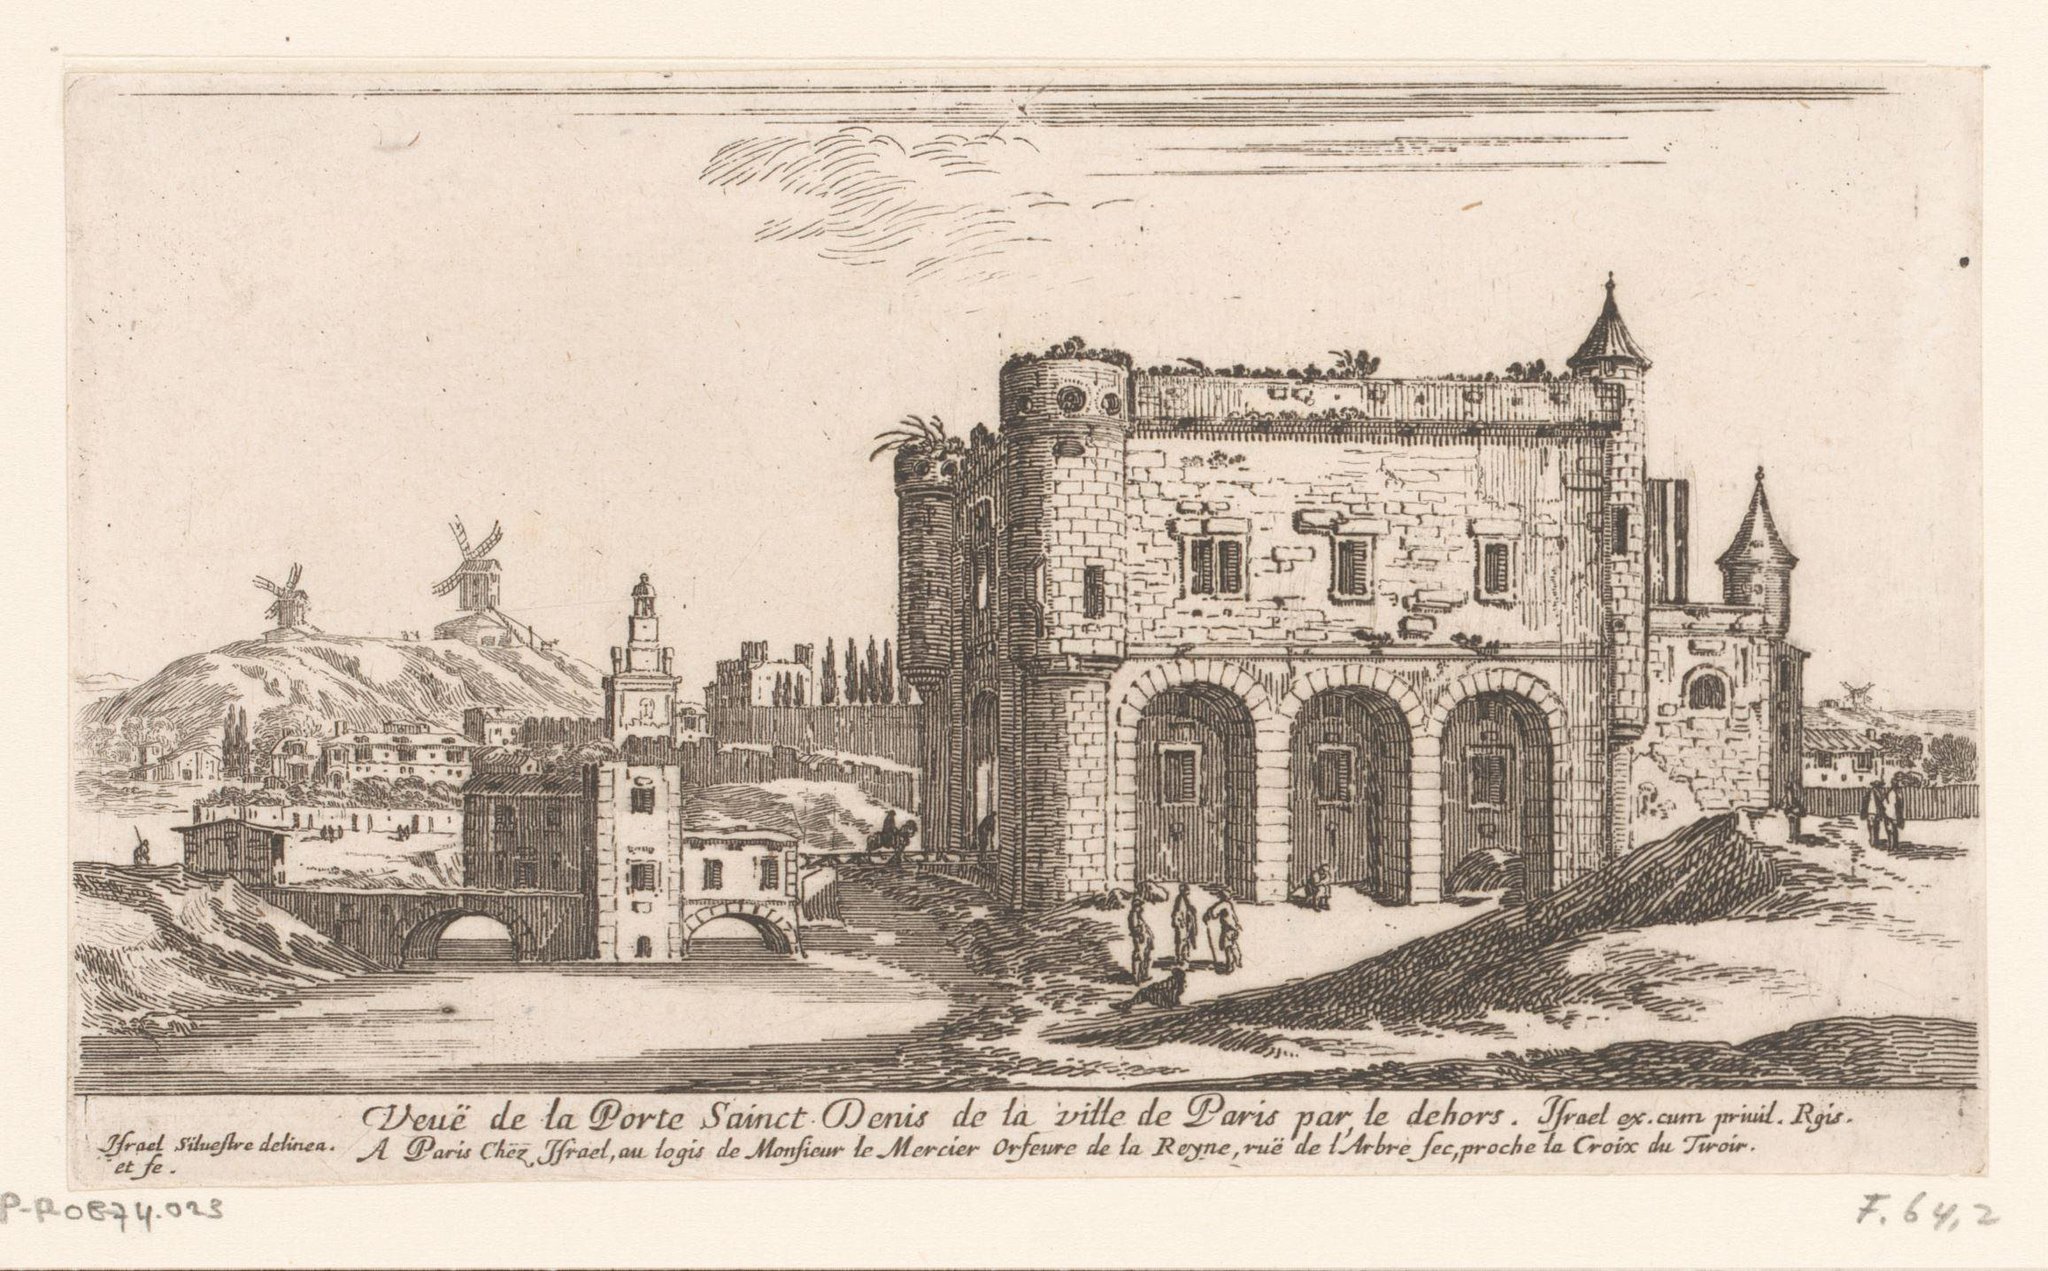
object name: print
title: Gezicht op de poort van Sint Denis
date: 1652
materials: paper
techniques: engraving, etching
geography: paris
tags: triumphal arch, landscape with tower or castle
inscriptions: collector's mark: Lugt 240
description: Prent maakt deel uit van een ongenummerde serie van 30 prenten.